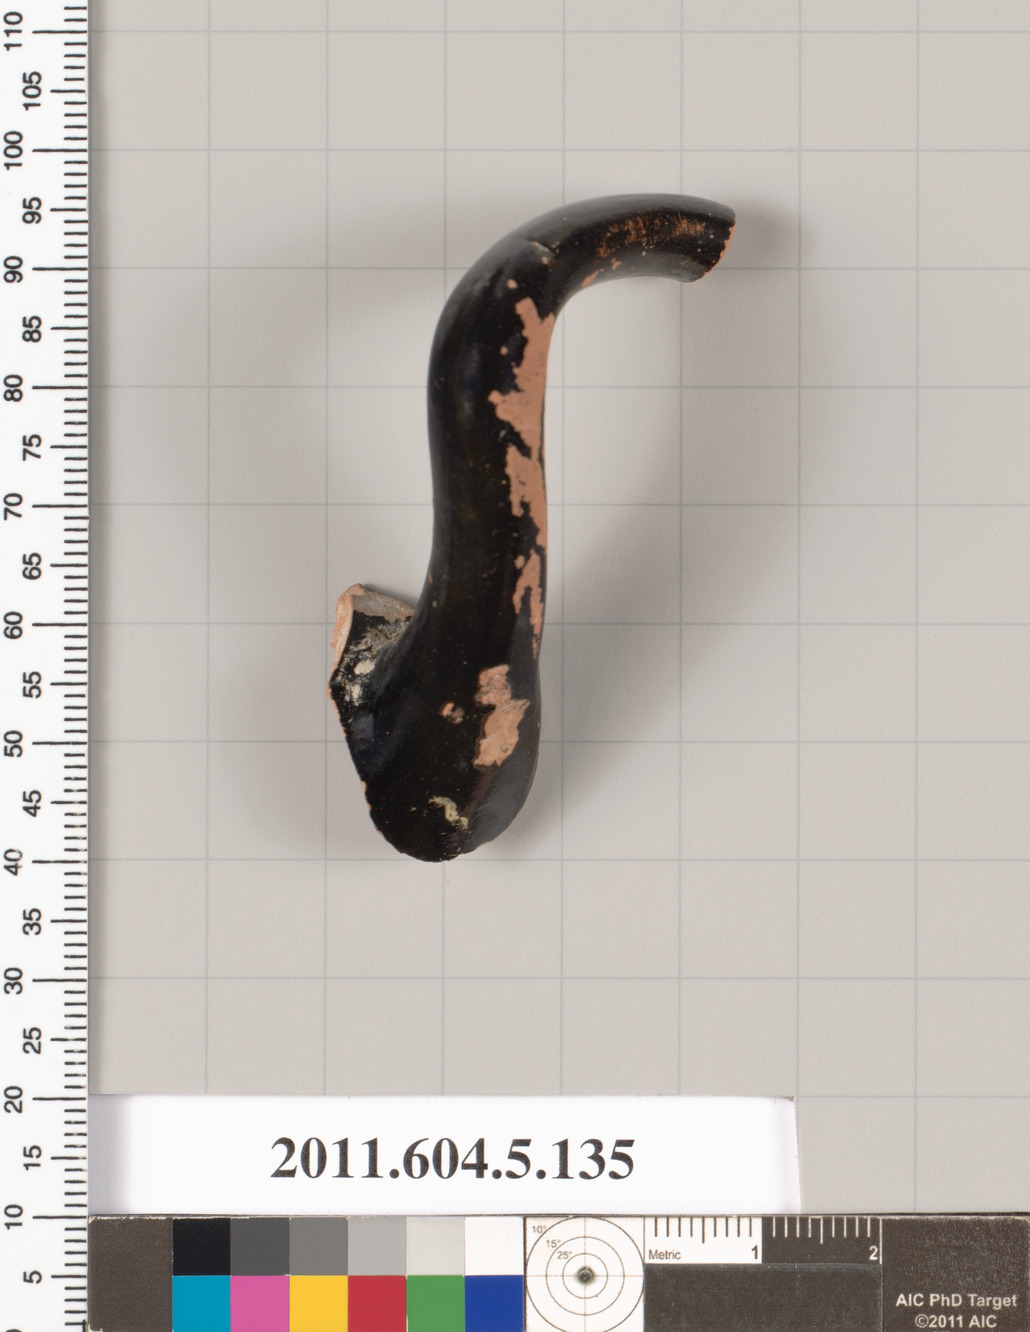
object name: kylix fragment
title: Terracotta fragment of a kylix (drinking cup)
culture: greek, attic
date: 470-450 BCE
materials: terracotta